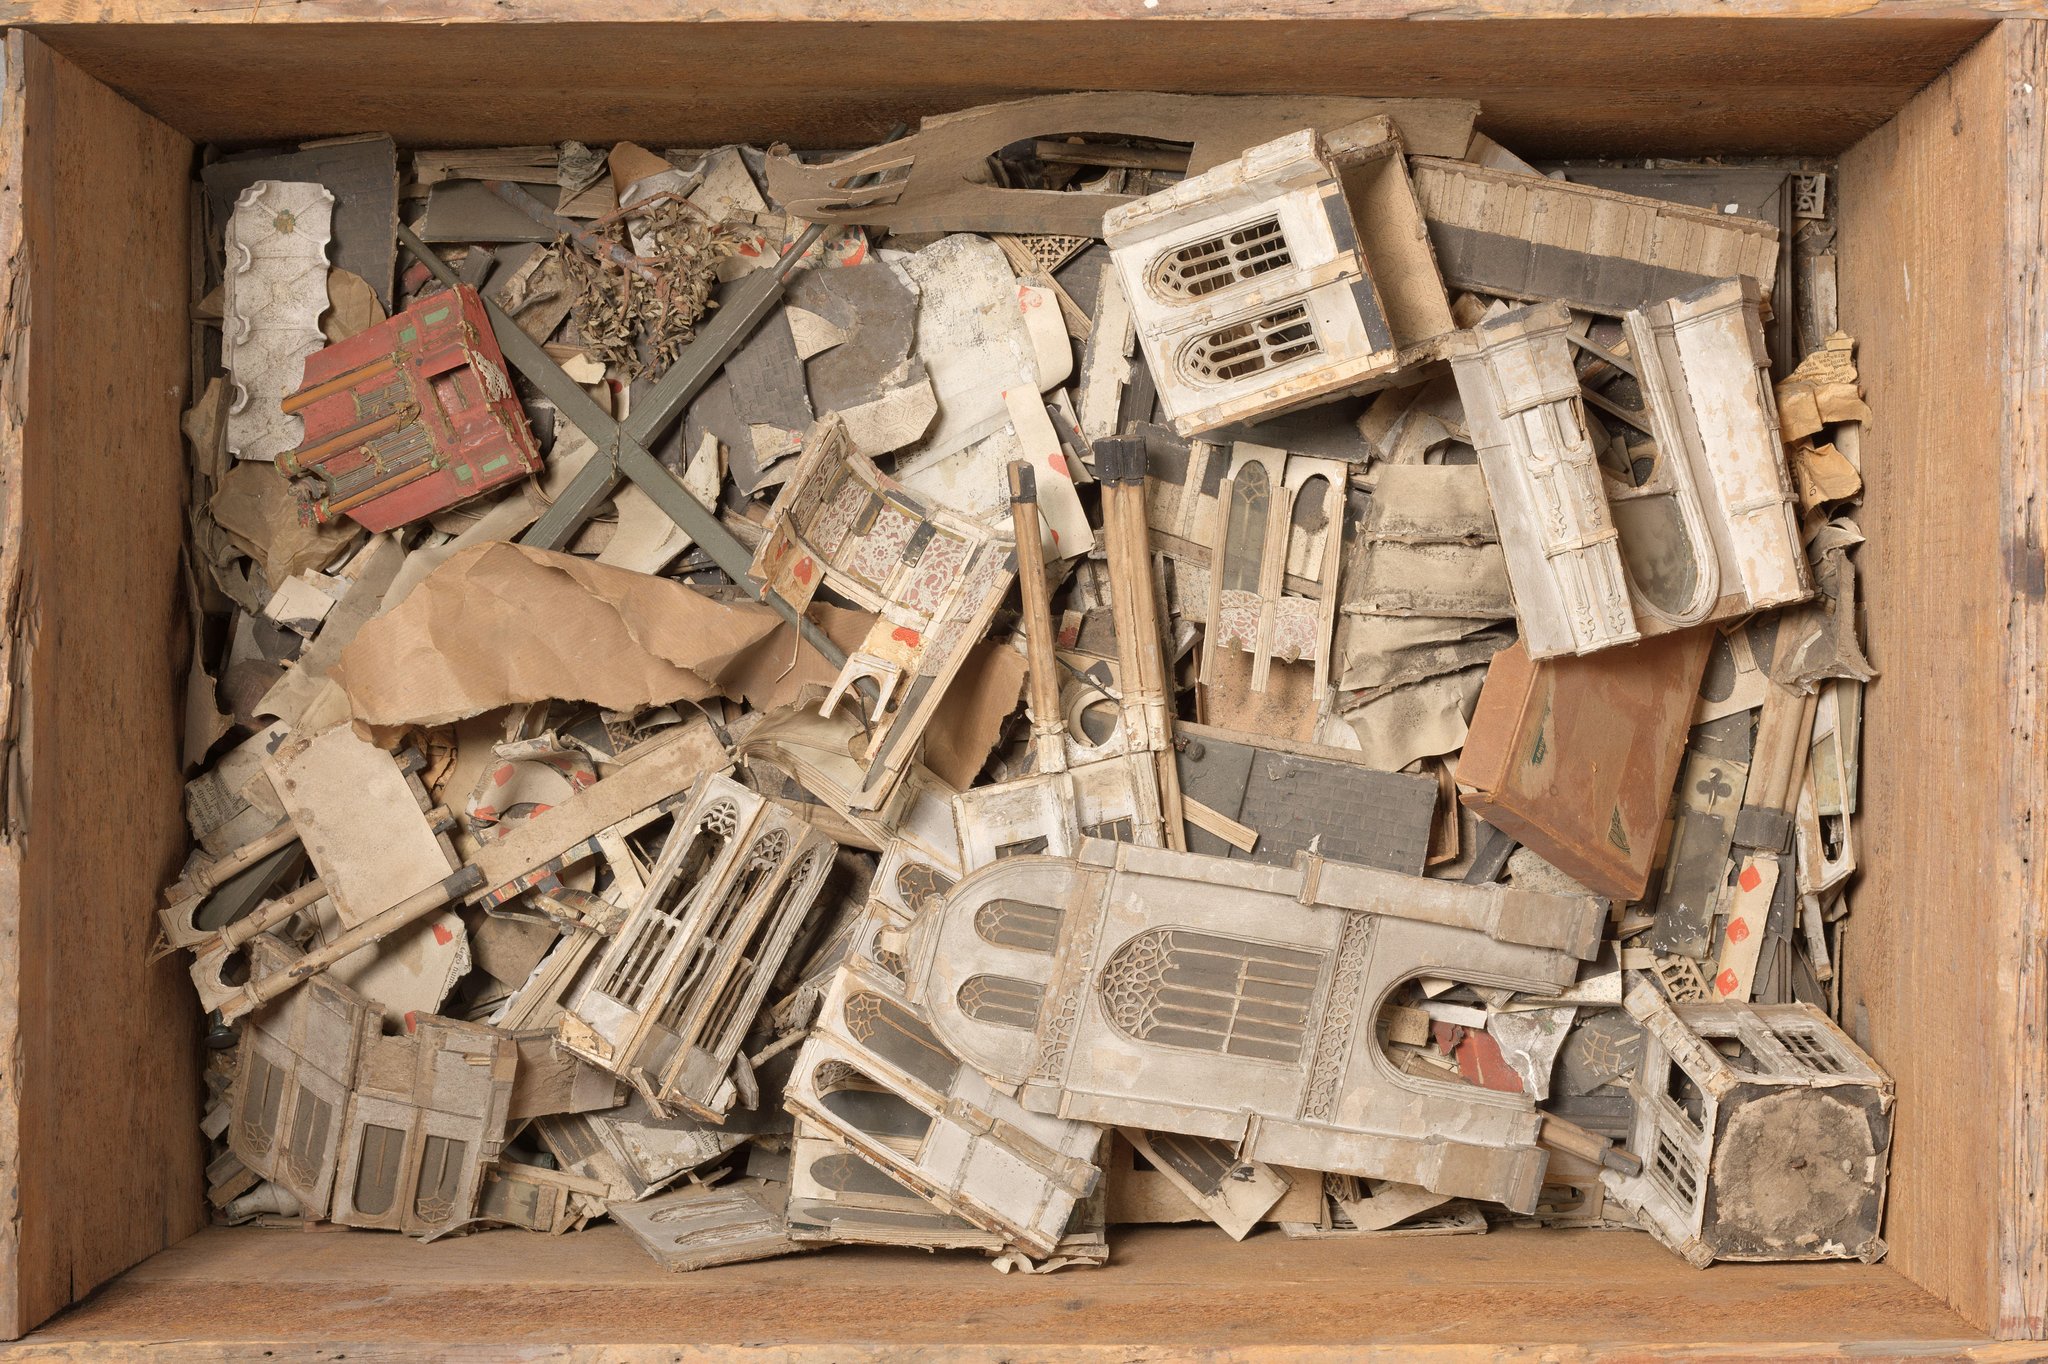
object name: maquette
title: Model van Gotische kerk met toren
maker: Anonymous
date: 1800-1875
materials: cardboard, wood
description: Model van hout en karton van een Gotische kerk met toren.